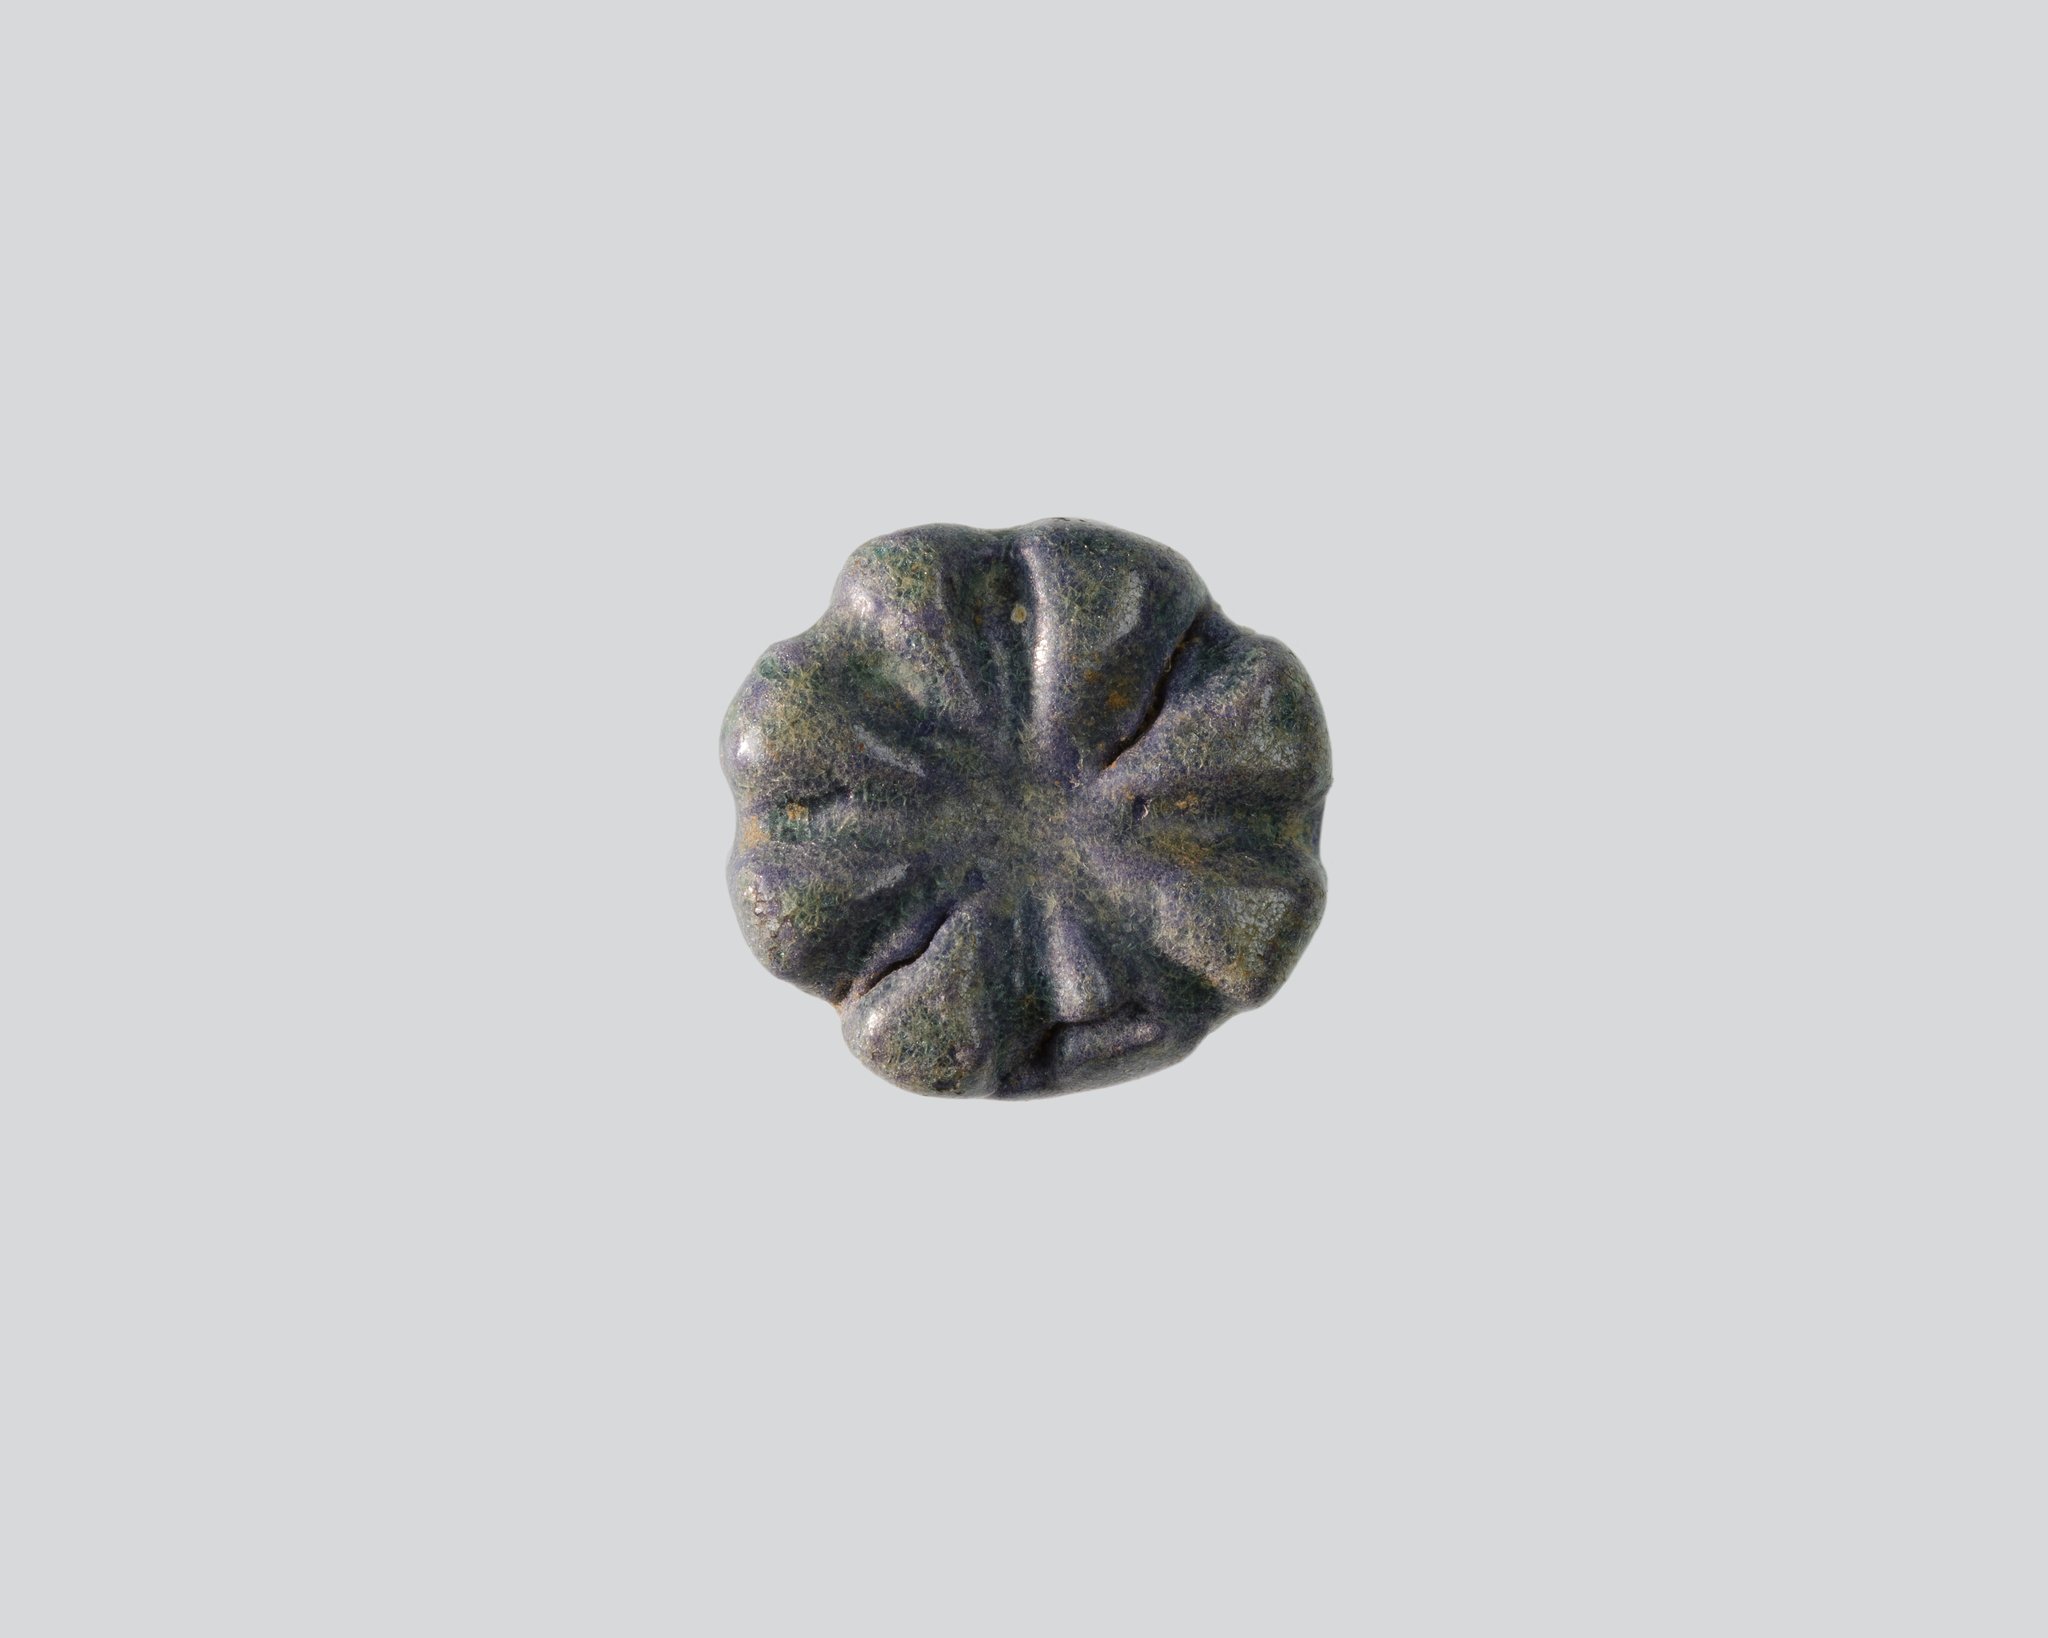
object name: pendant, cornflower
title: Cornflower Pendant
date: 1390-1352 BCE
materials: faience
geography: egypt